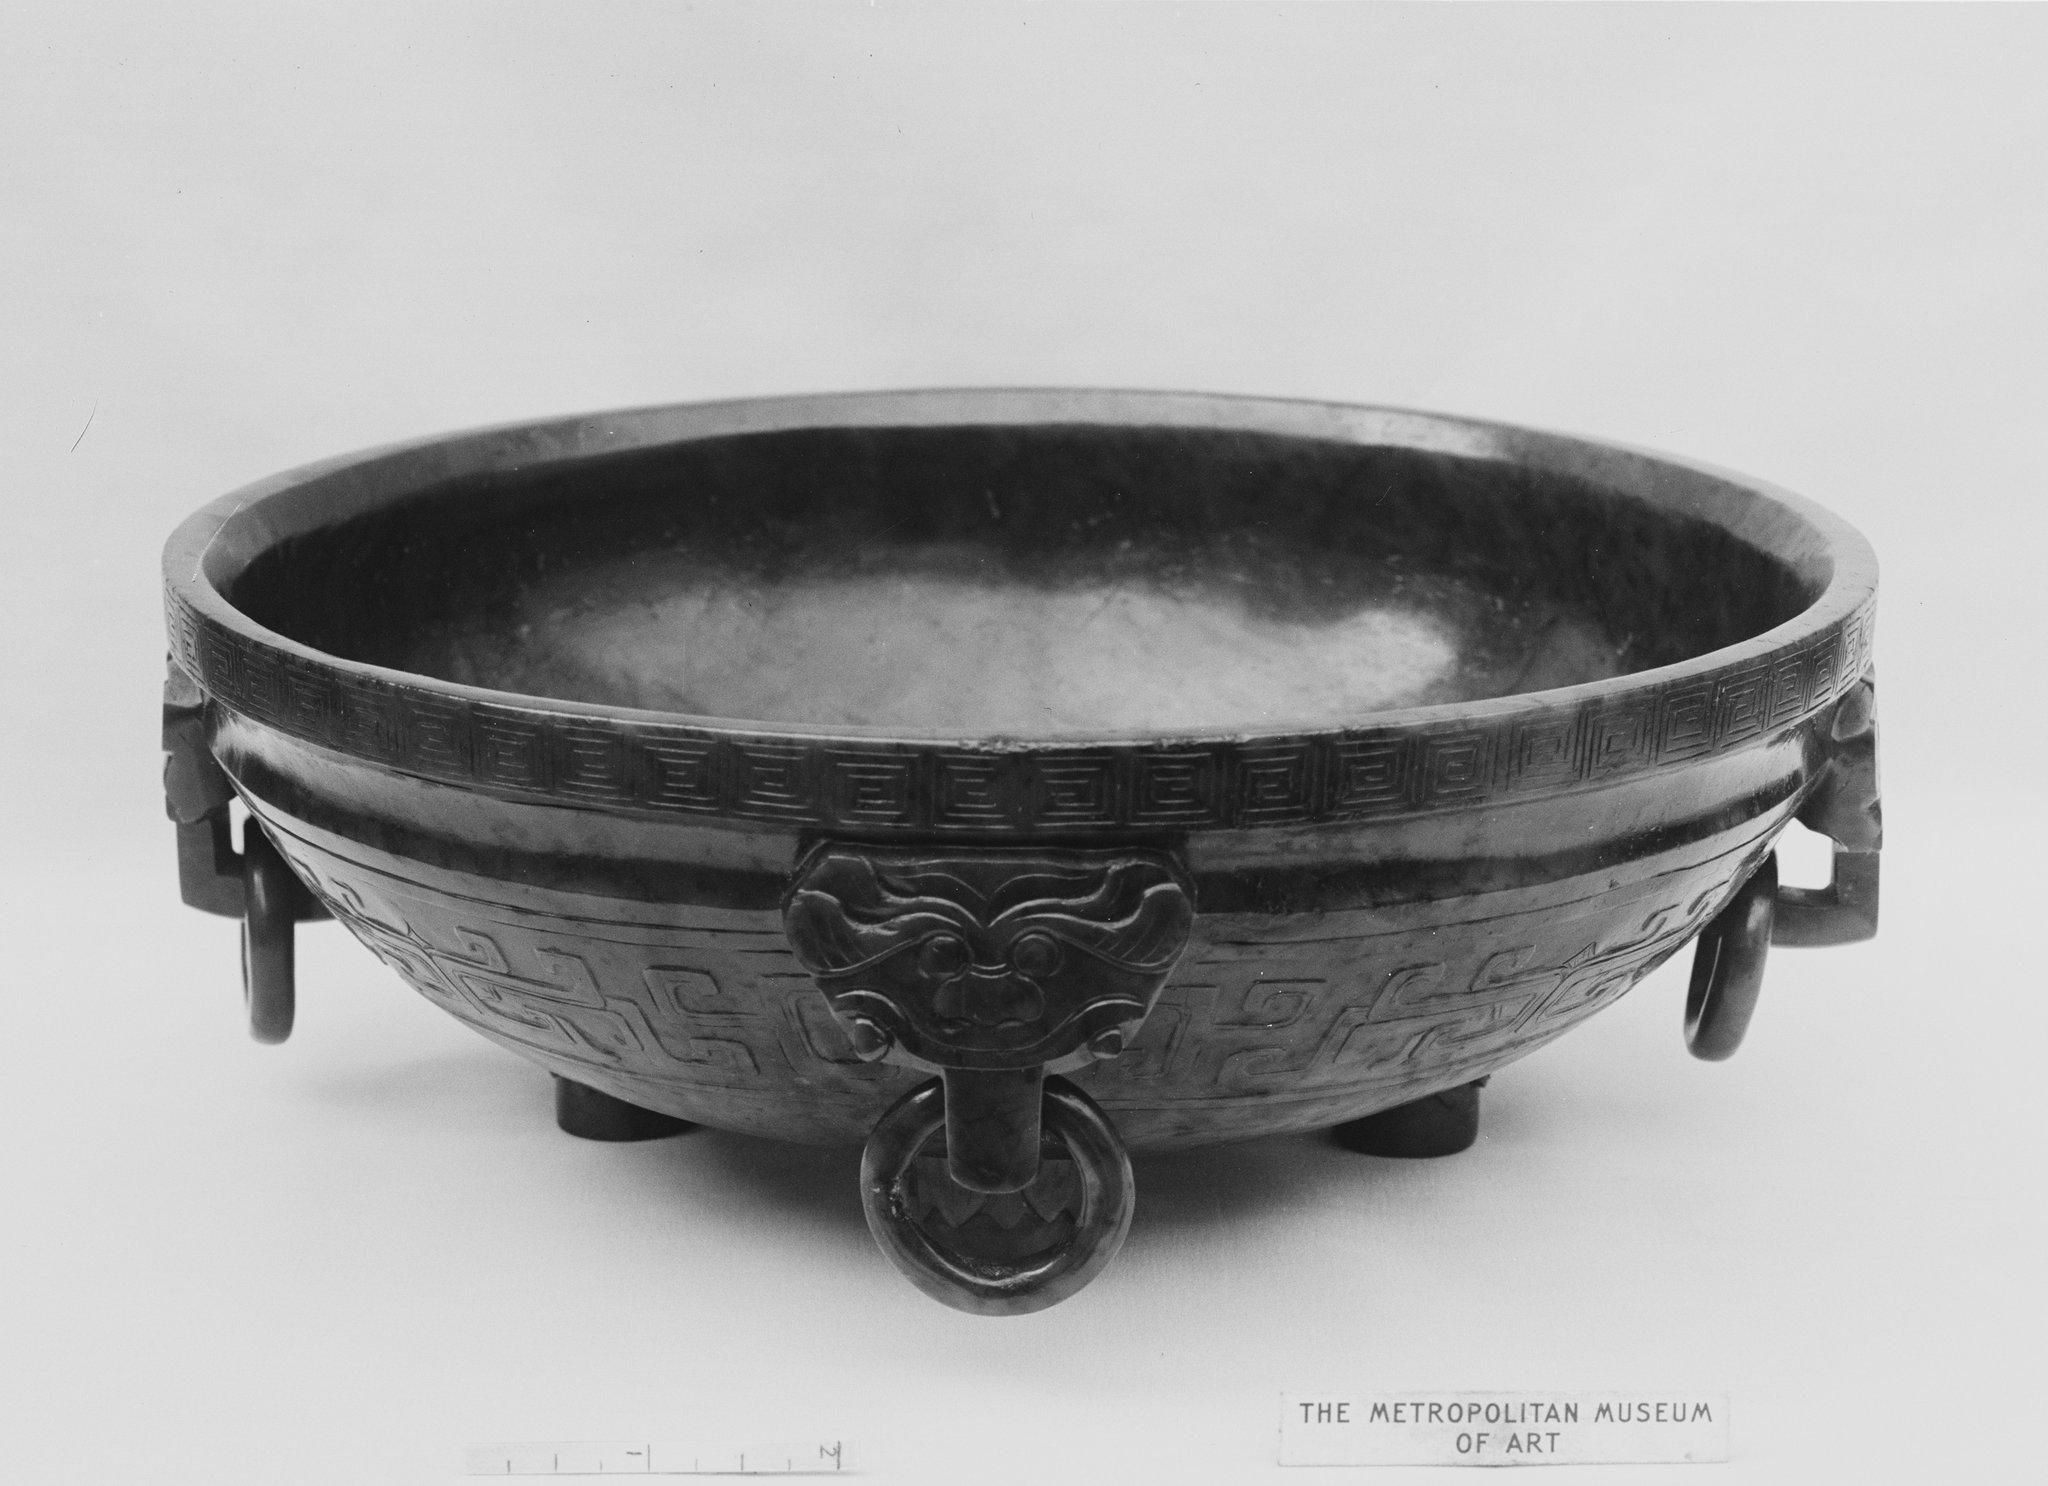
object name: bowl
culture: chinese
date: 1736-1795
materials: jade